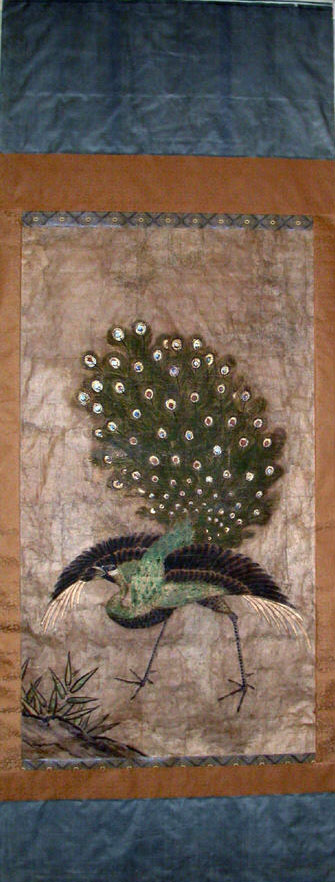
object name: hanging scroll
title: Peacock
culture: japanese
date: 1601-1700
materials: ink, paper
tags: peacocks